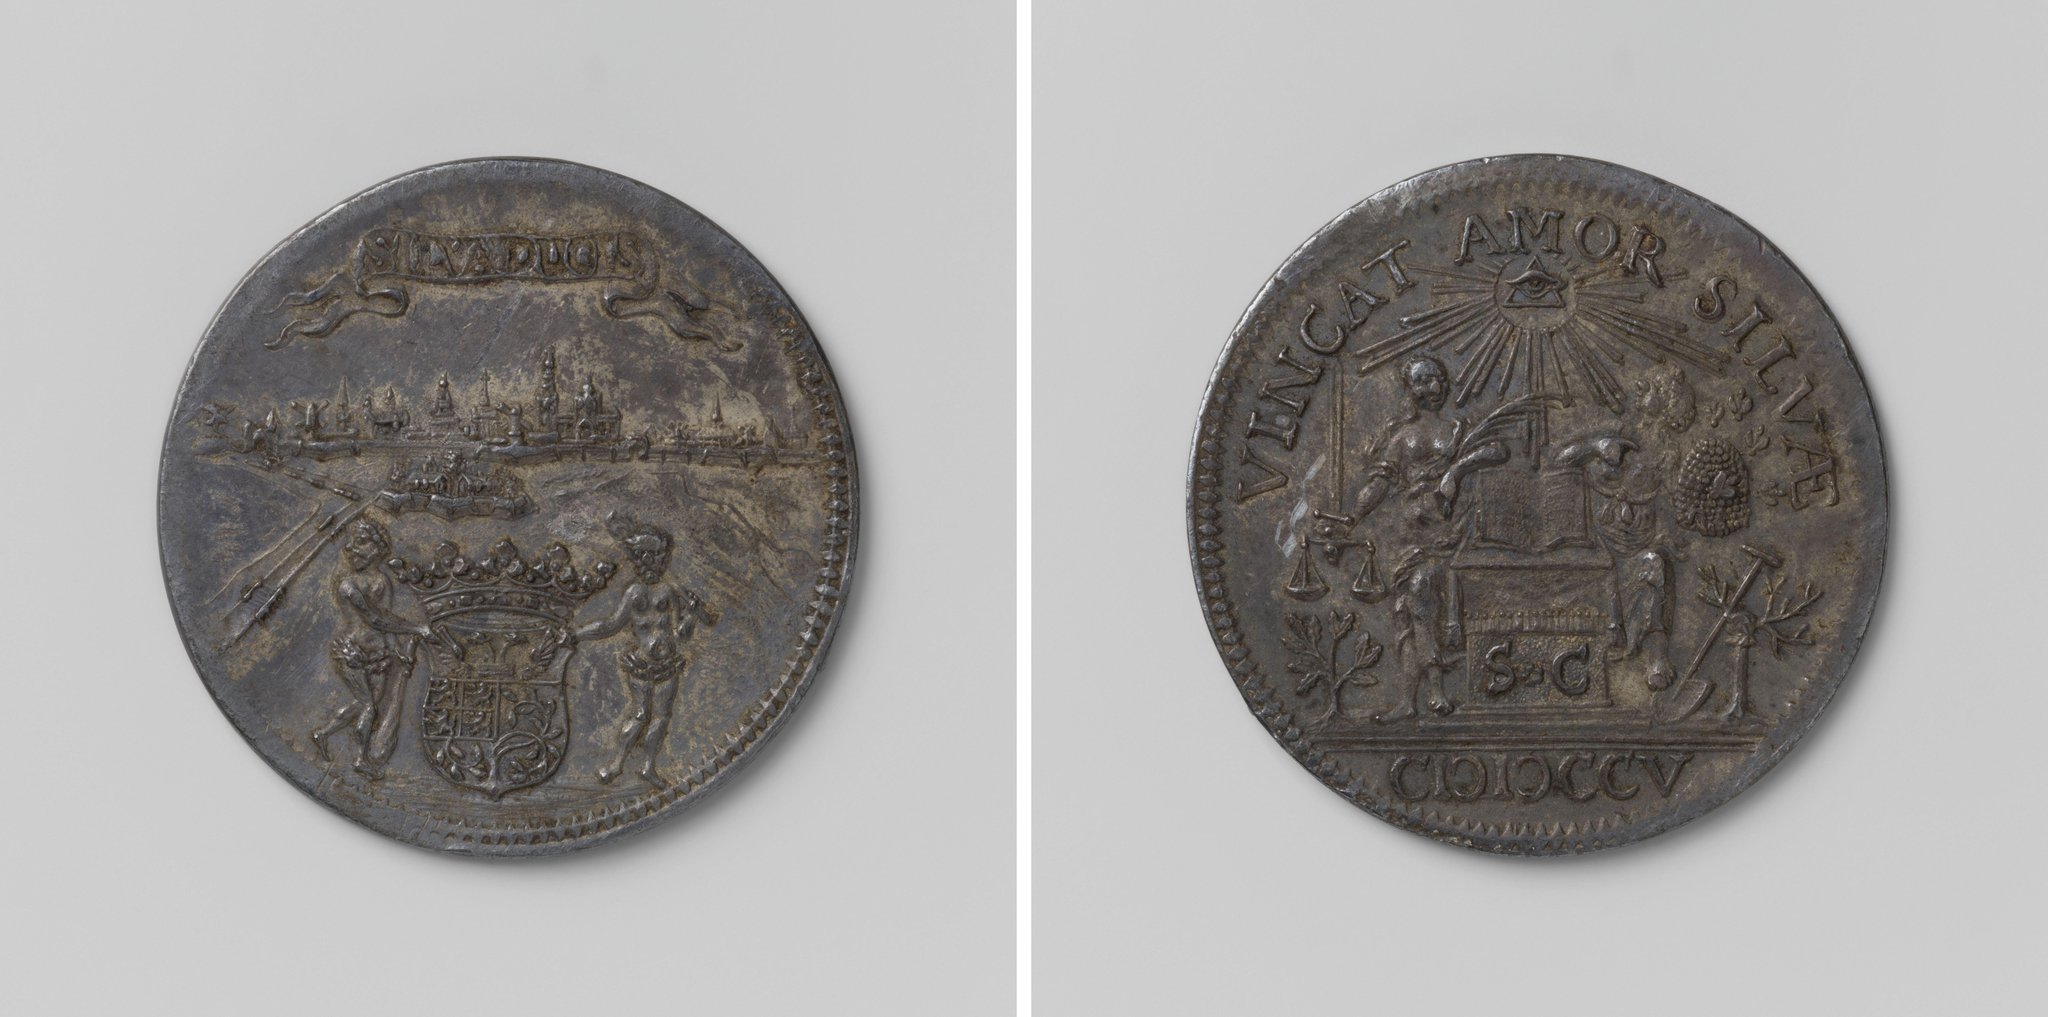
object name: council medal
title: Vroedschapspenning van de stad 's-Hertogenbosch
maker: theodorus casparus van berckel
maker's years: 1680-1734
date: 1705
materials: silver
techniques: striking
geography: den bosch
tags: den bosch